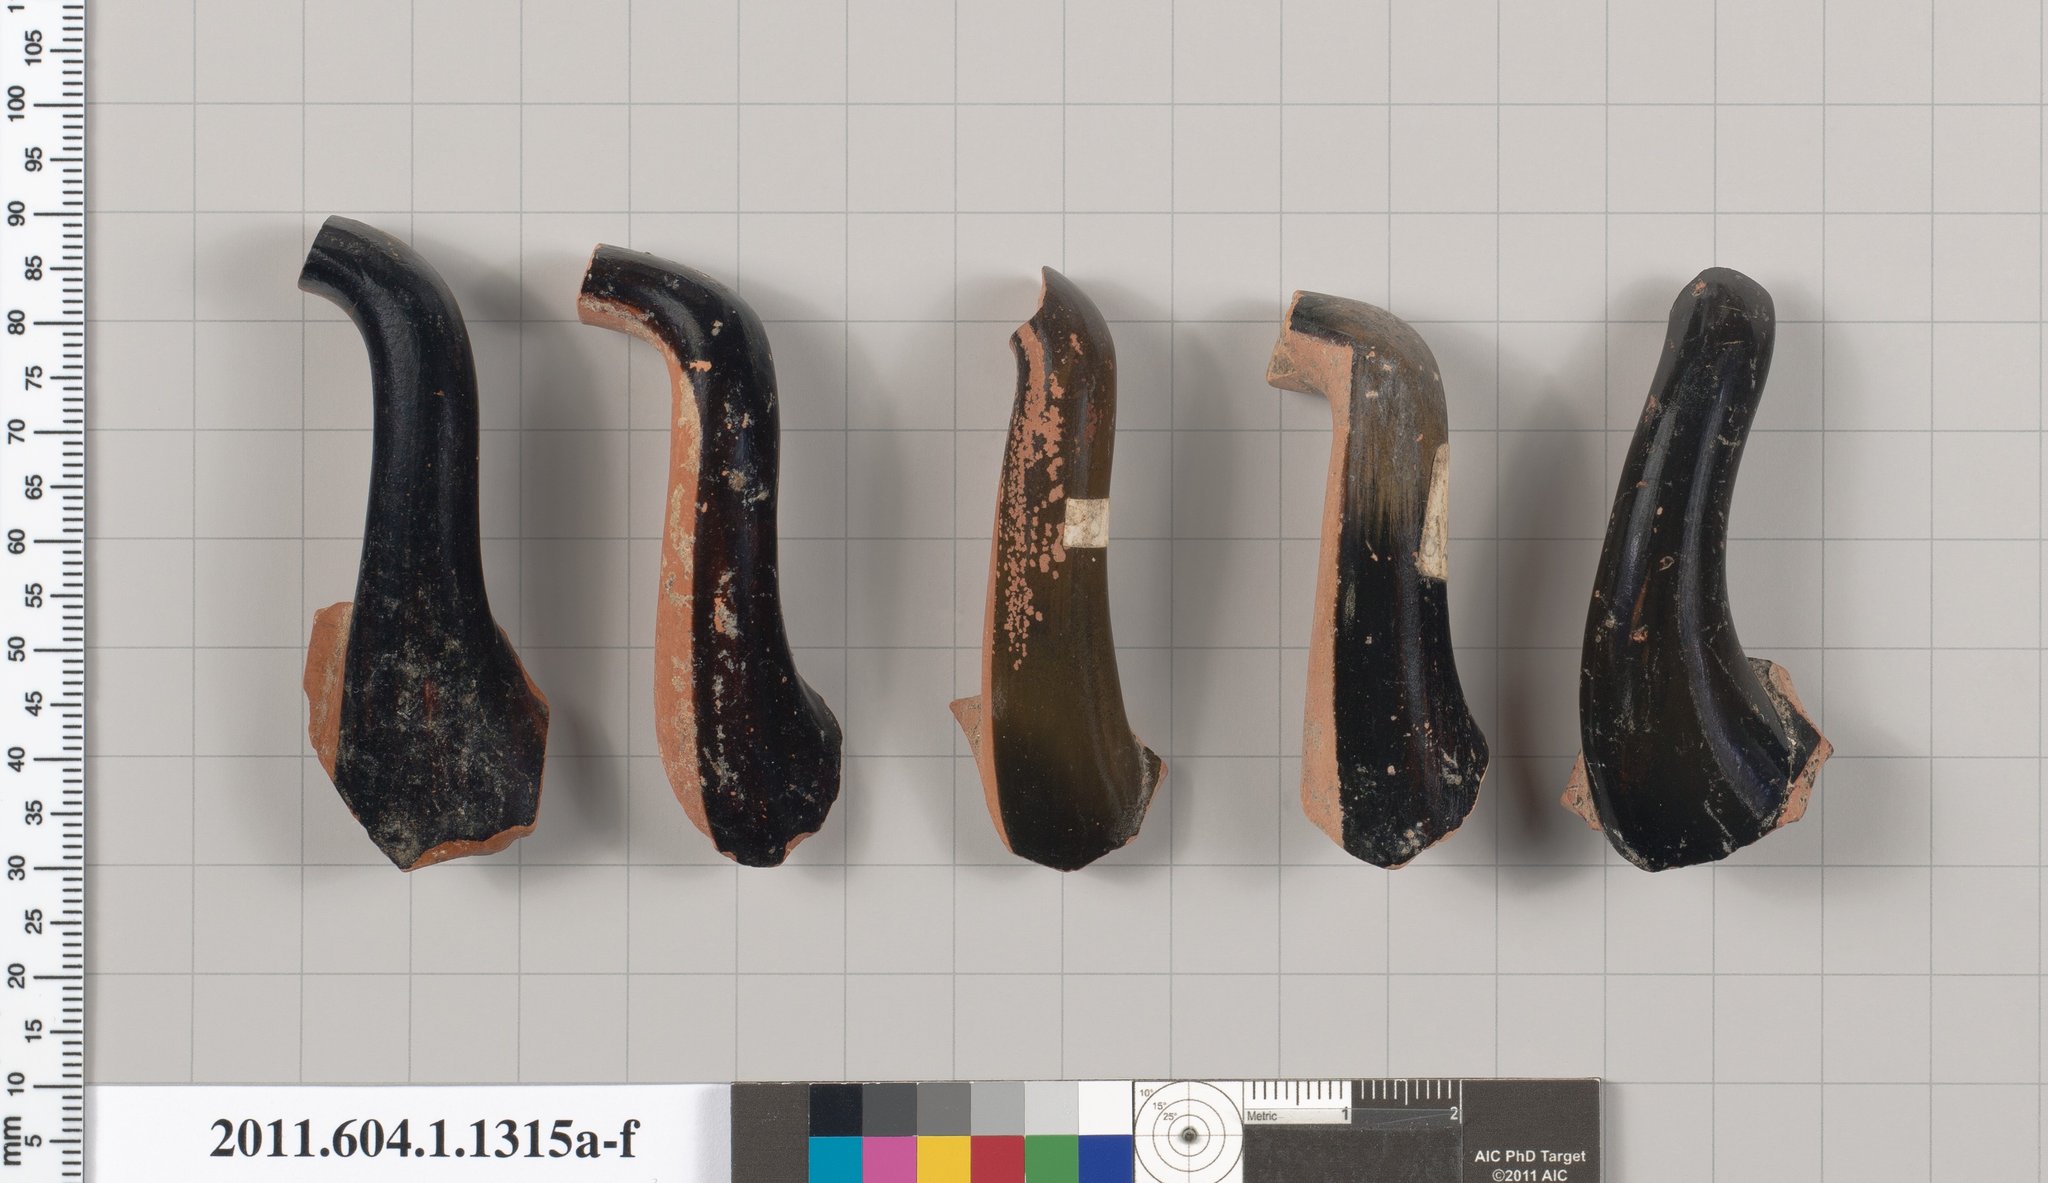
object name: kylix fragment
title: Terracotta fragments of kylikes (drinking cups)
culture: greek, attic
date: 500-401 BCE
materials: terracotta